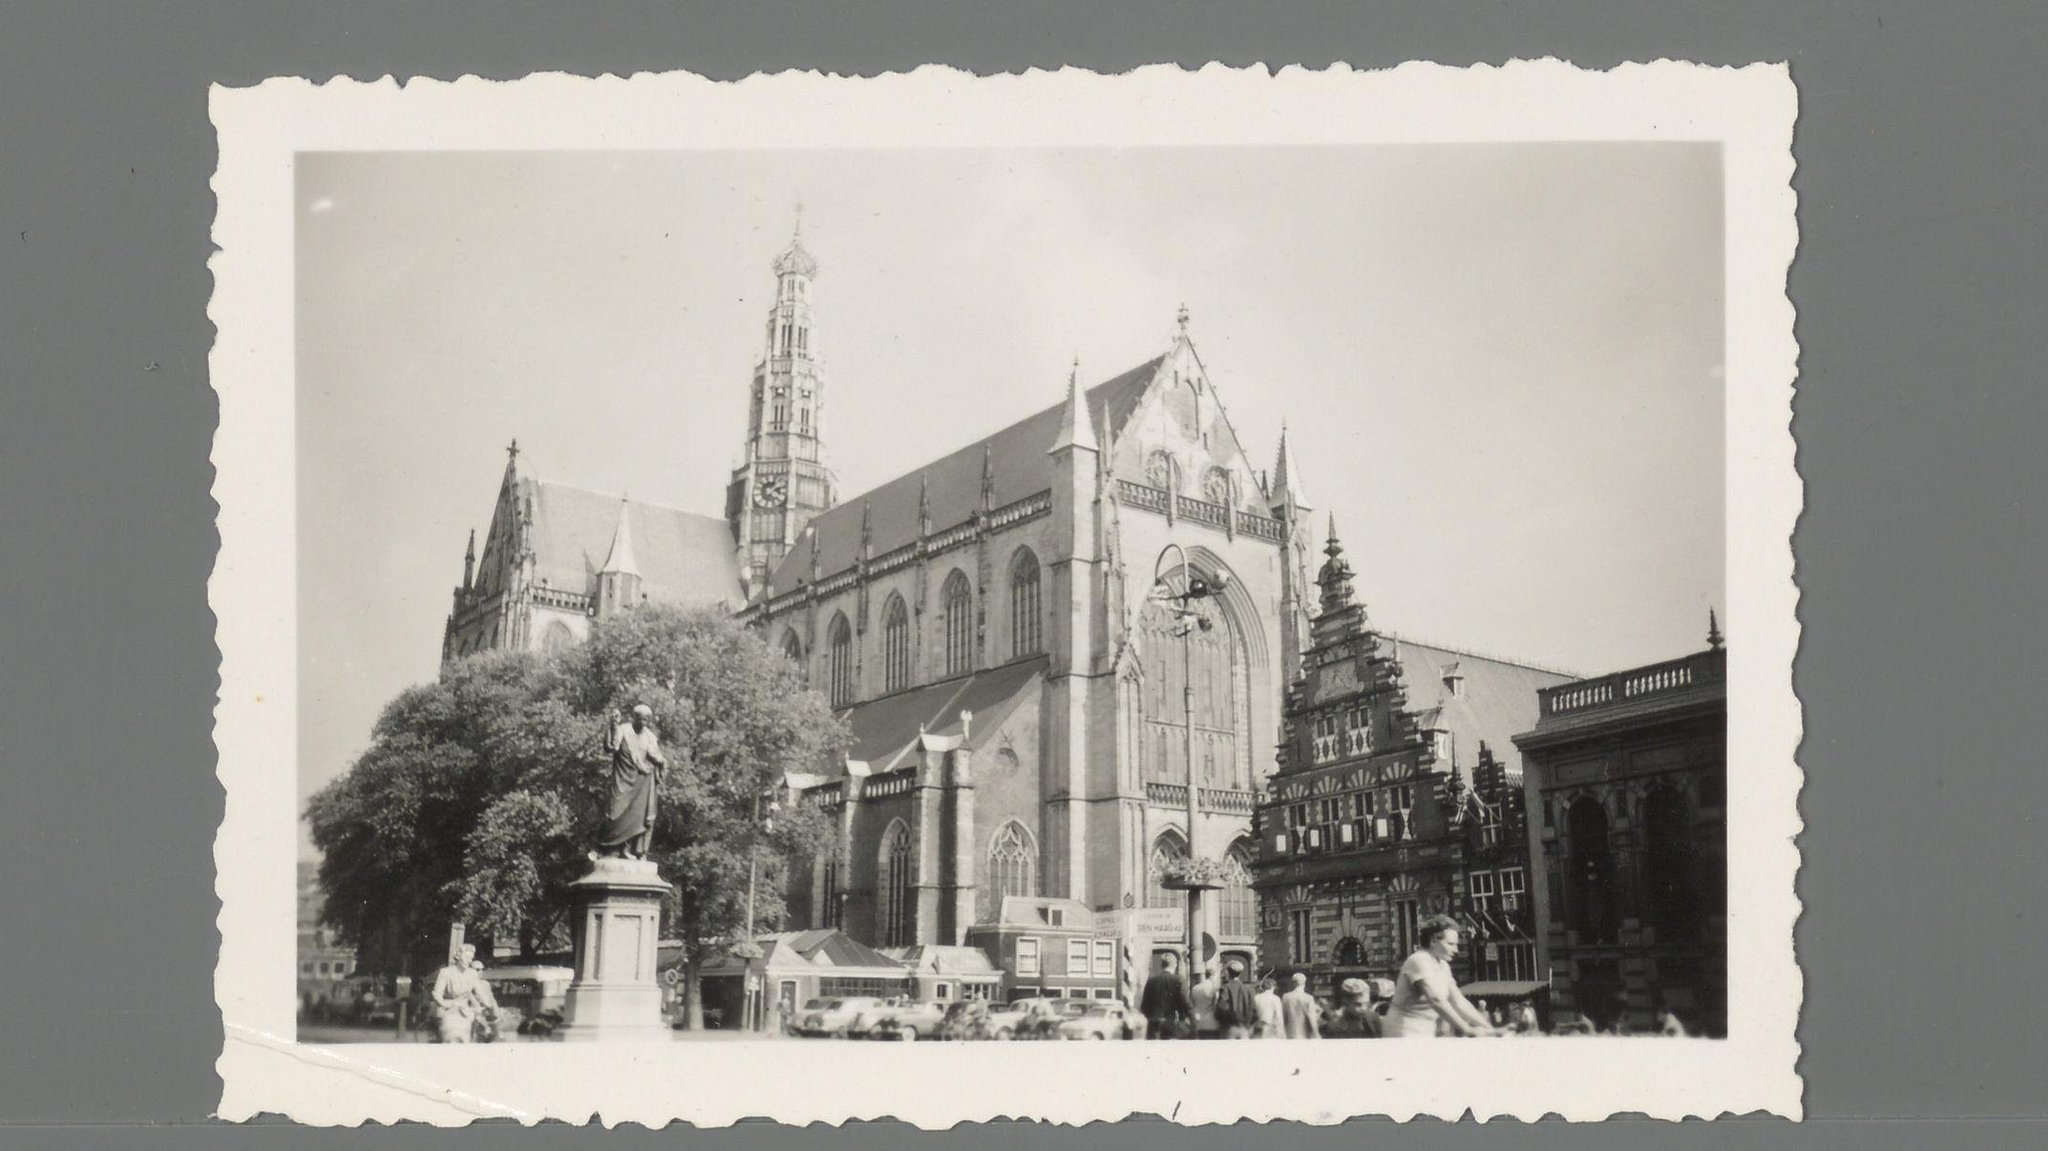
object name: photograph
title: Gezicht op de Grote of Sint-Bavokathedraal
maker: Anonymous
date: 1954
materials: paper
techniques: gelatin silver print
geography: haarlem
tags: church (exterior)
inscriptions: inscription: ‘Haarlem St. Baaf 1914’, factory mark: ‘Velox’